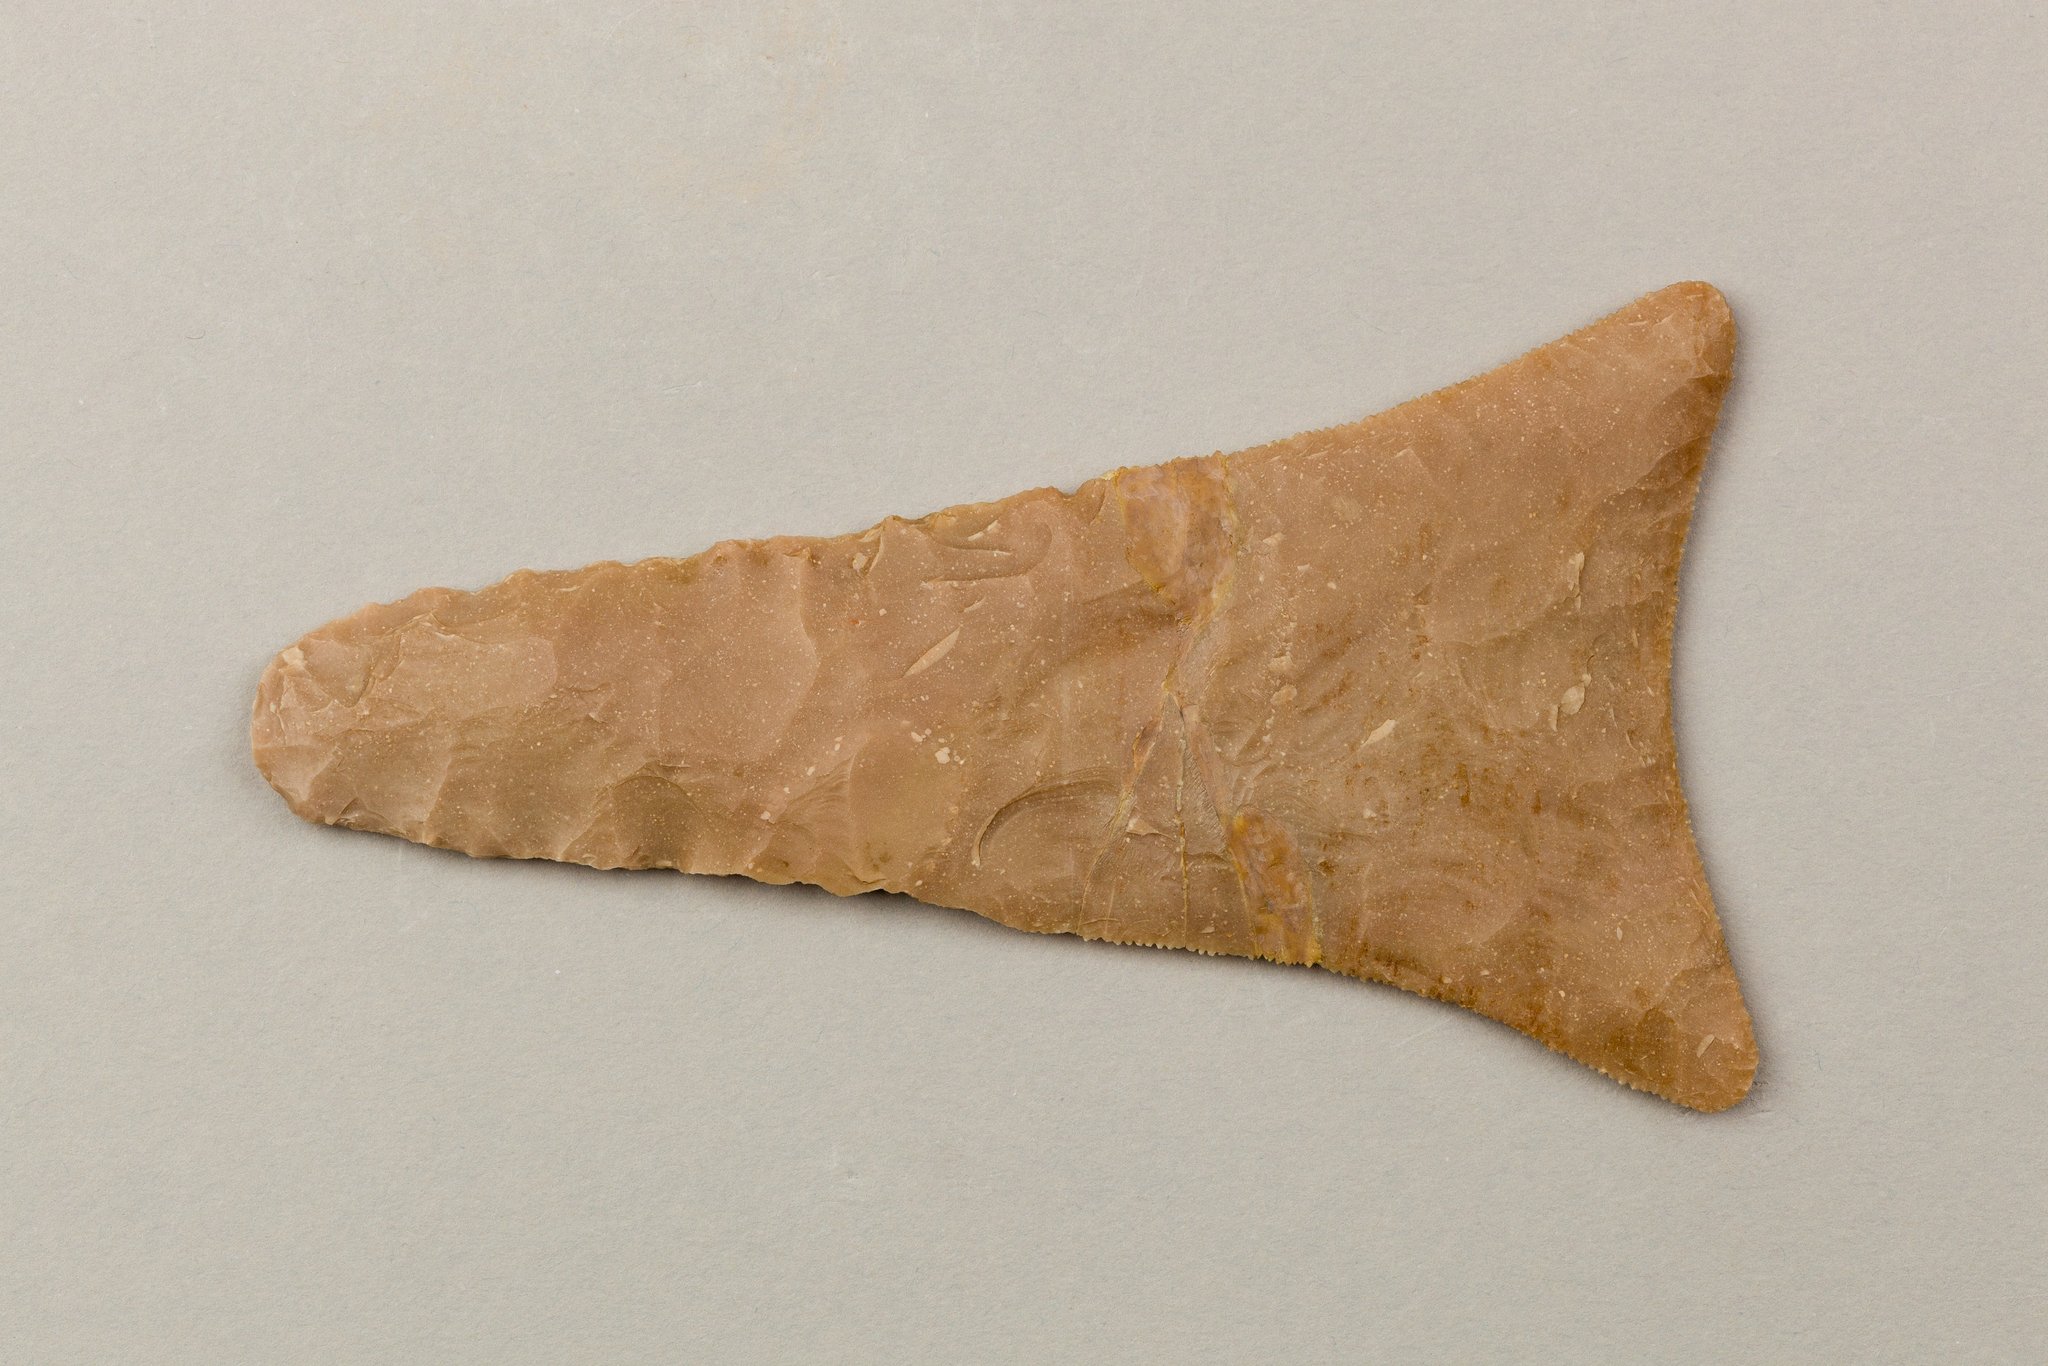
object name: knife, fishtail, bifacial knife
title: Fishtail Knife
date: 3850-2960 BCE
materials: stone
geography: egypt